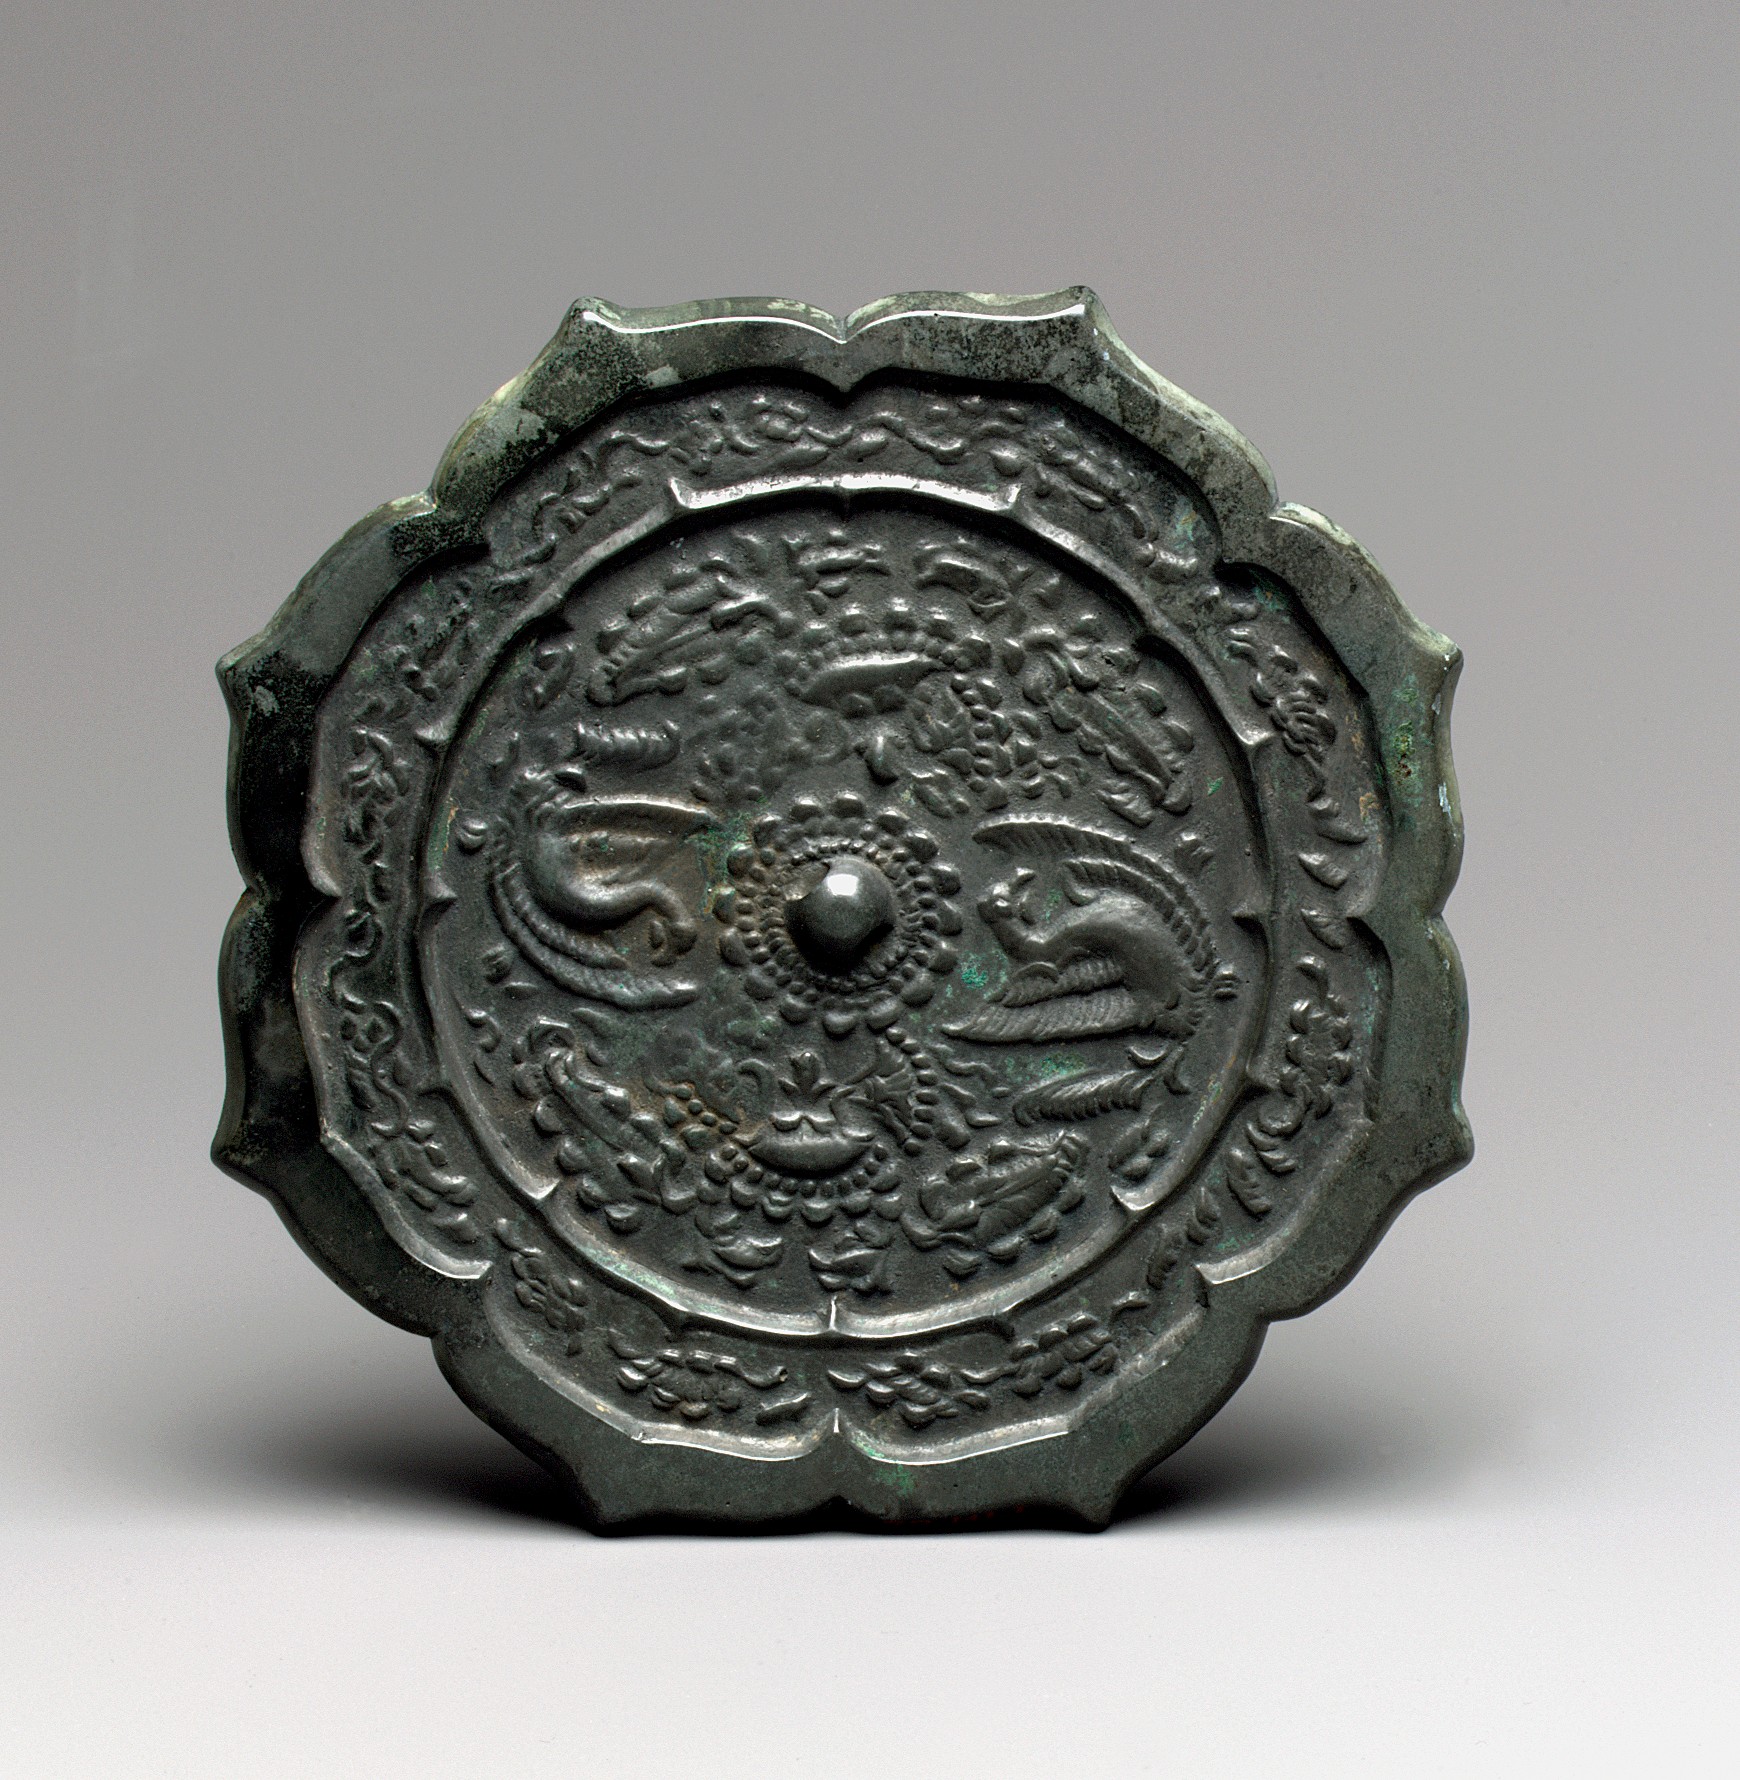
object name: mirror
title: Mirror decorated with phoenixes and flowers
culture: korean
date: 1101-1150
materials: bronze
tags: phoenix